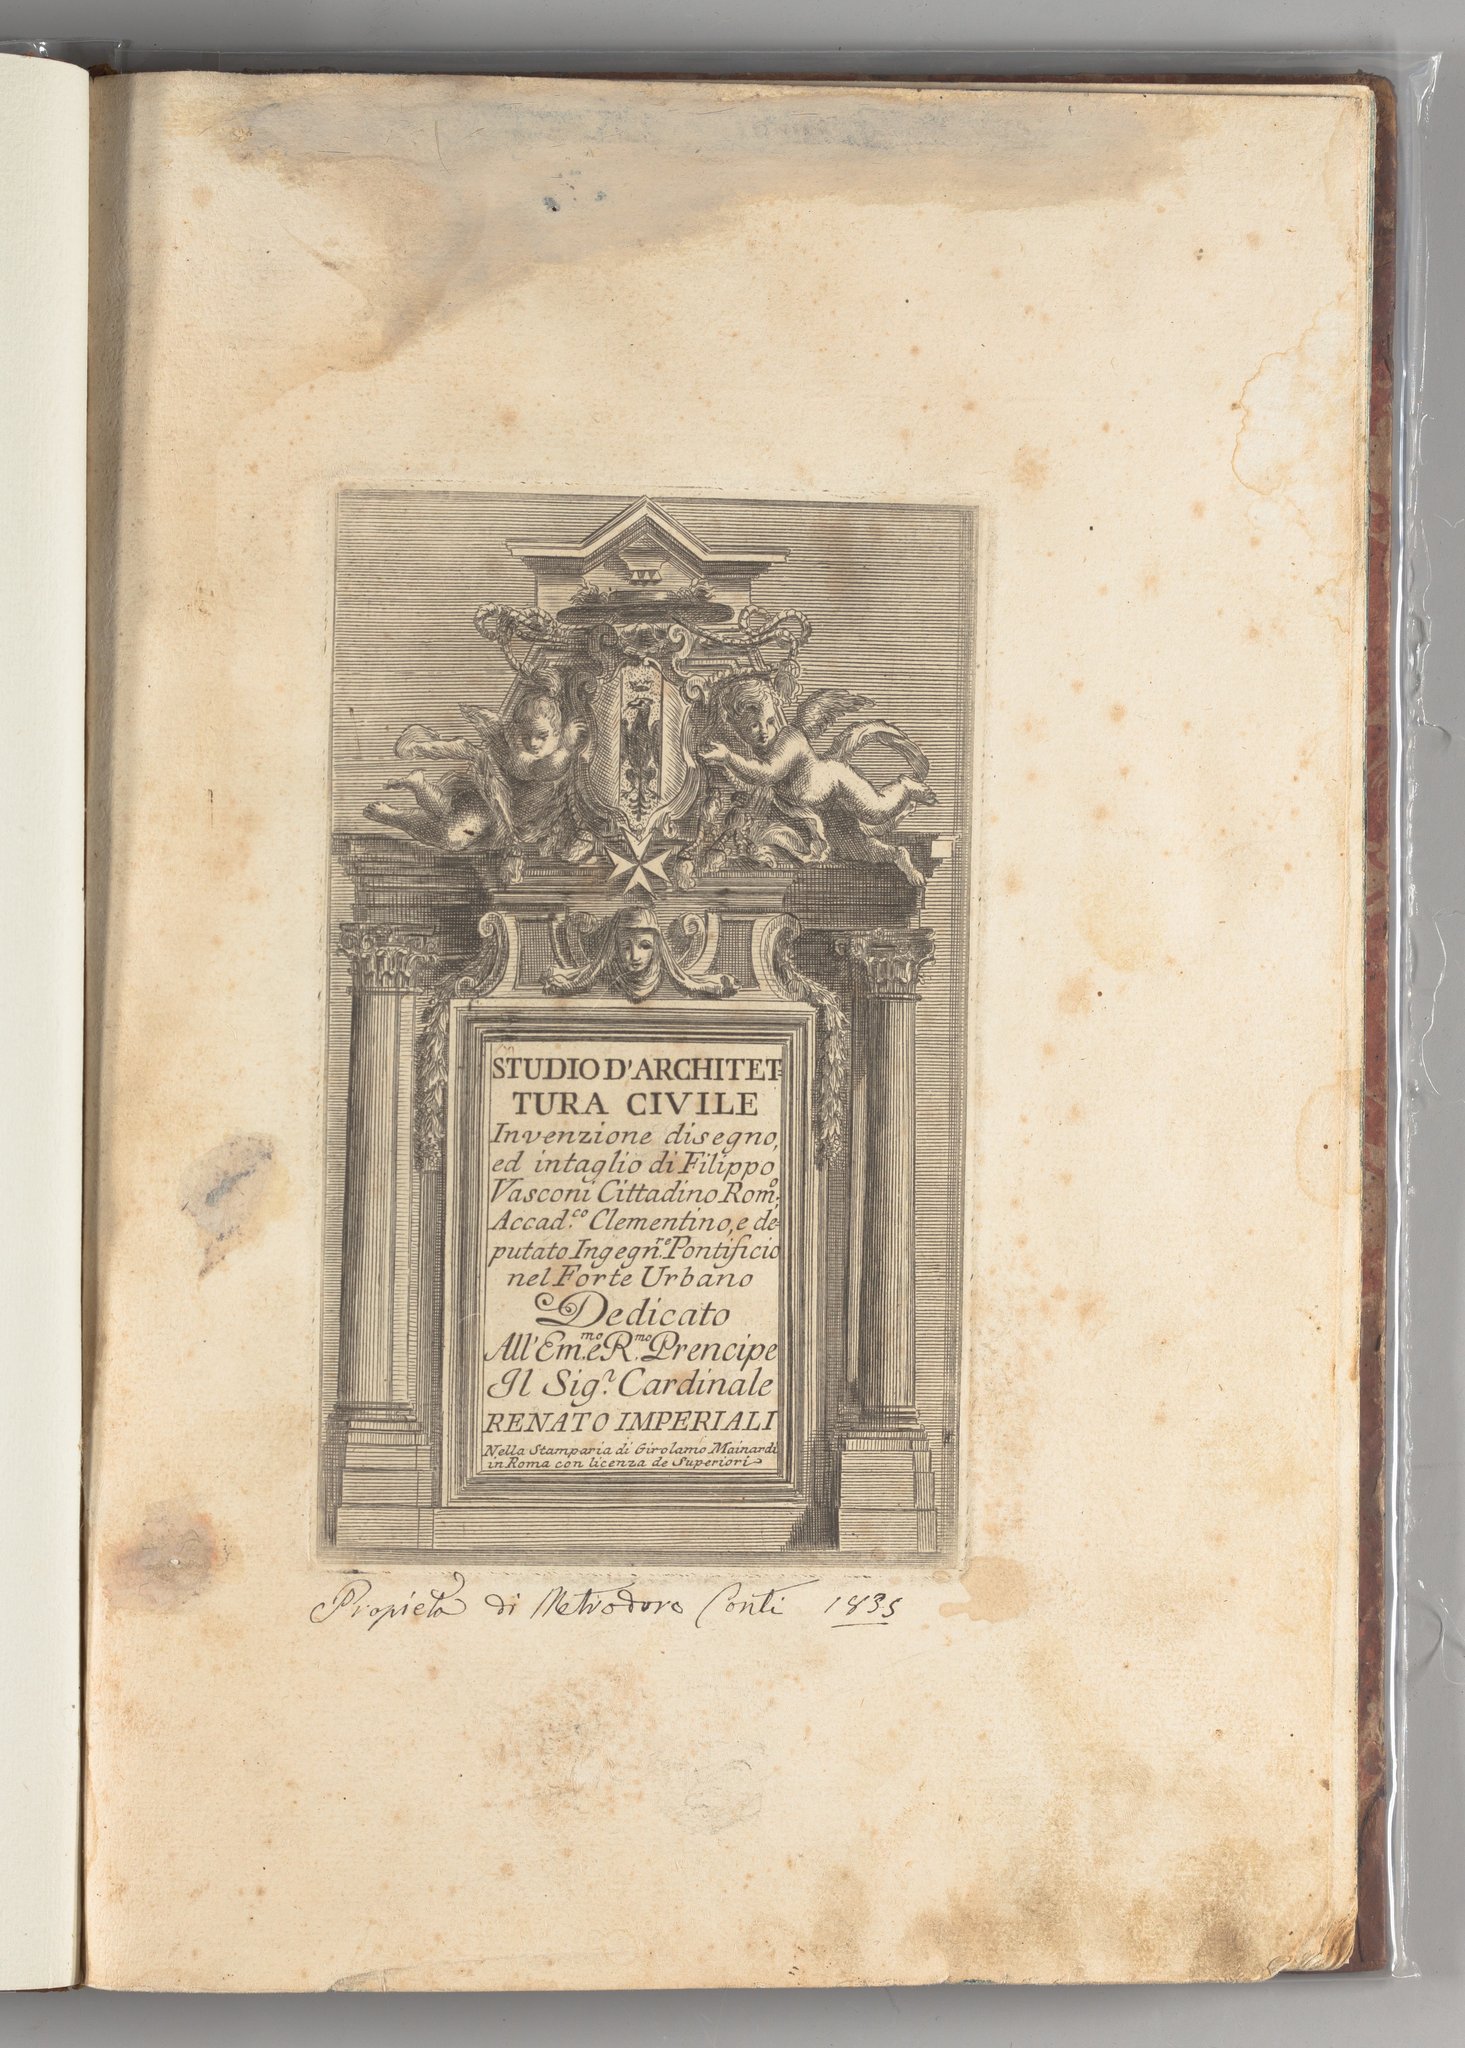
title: Studio d'architettura civile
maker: filippo vasconi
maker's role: author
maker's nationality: italian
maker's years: 1687-1730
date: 1725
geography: italy